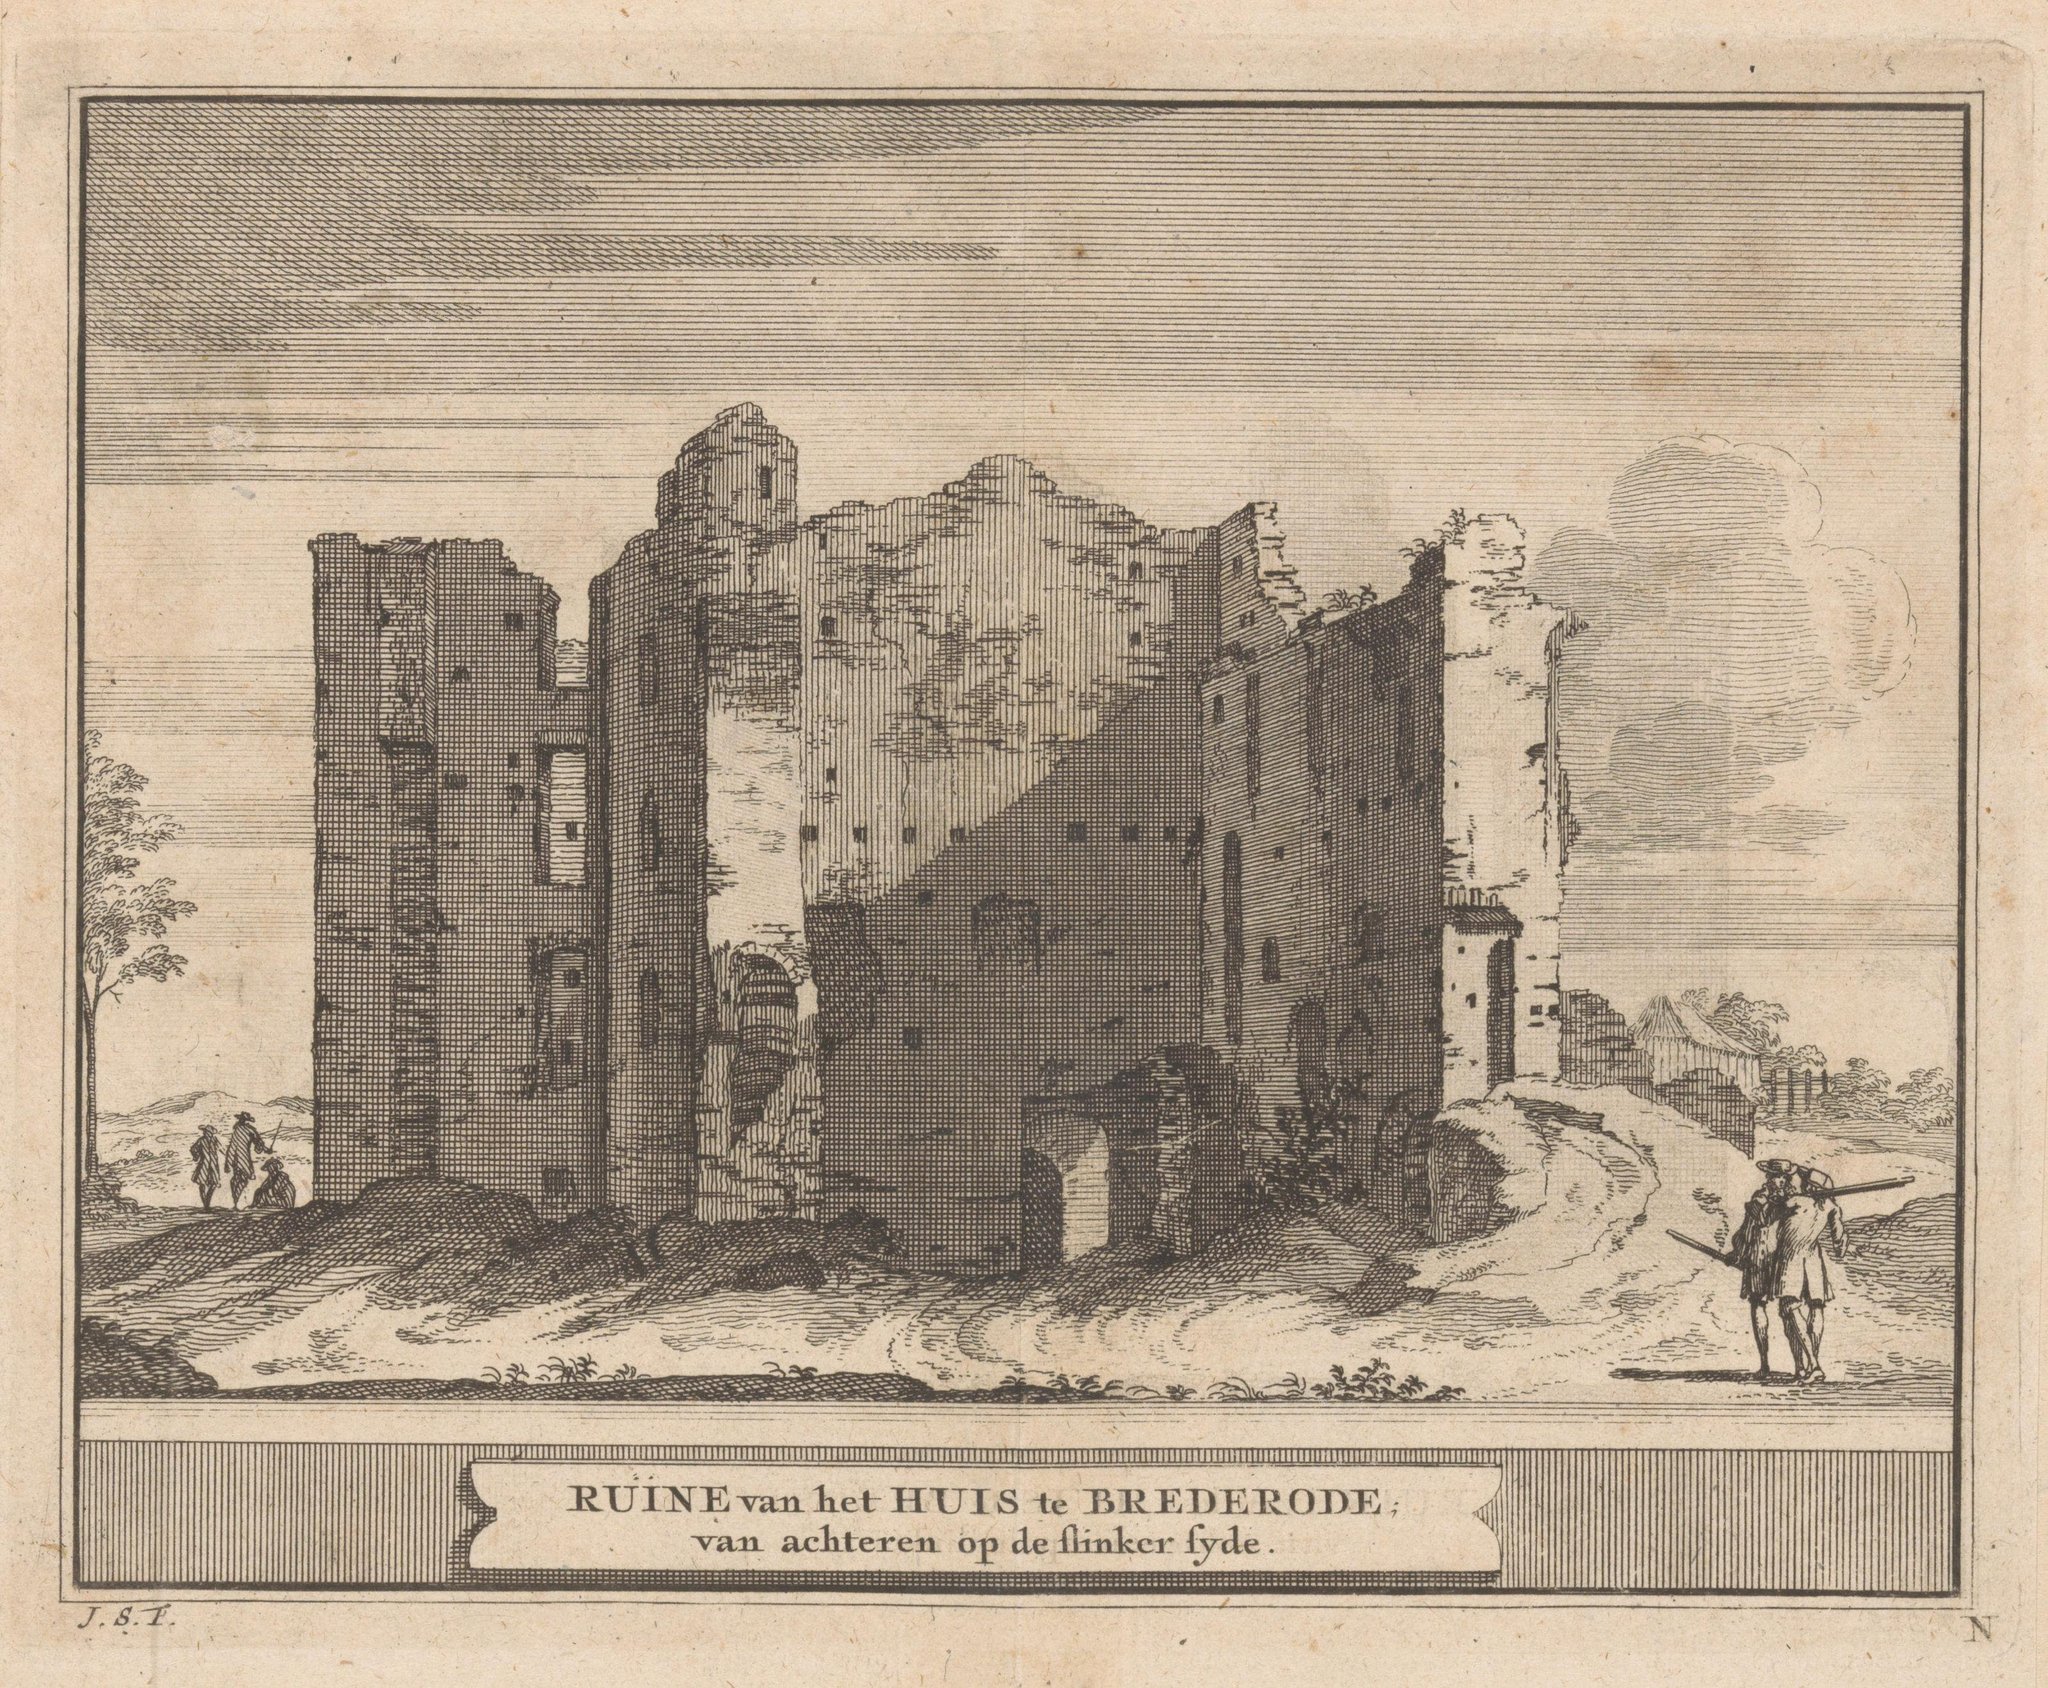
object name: book illustration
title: Gezicht op de ruïne van Kasteel Brederode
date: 1711-1774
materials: paper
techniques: engraving, etching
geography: amsterdam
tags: ruin of a dwelling, house, castle, etc.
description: Prent ook gebruikt in: Smids, Ludolf. Schatkamer der Nederlandsse oudheden; of woordenboek, behelsende Nederlands steden en dorpen, kasteelen, sloten en heeren huysen (…). Amsterdam: Pieter de Coup, 1711, tussen p. 42 en 43. Het is ook mogelijk dat deze prent uit de tweede (1737) of derde (1774) druk komt, of uit een uitgave met alleen de prenten: Nederlandsche oudheden, bestaande in zestig verbeeldingen (...) gelegen in Holland, 't Sticht van Utrecht en Gelderland enz. Amsterdam: Hendrik Bosch, 1721.